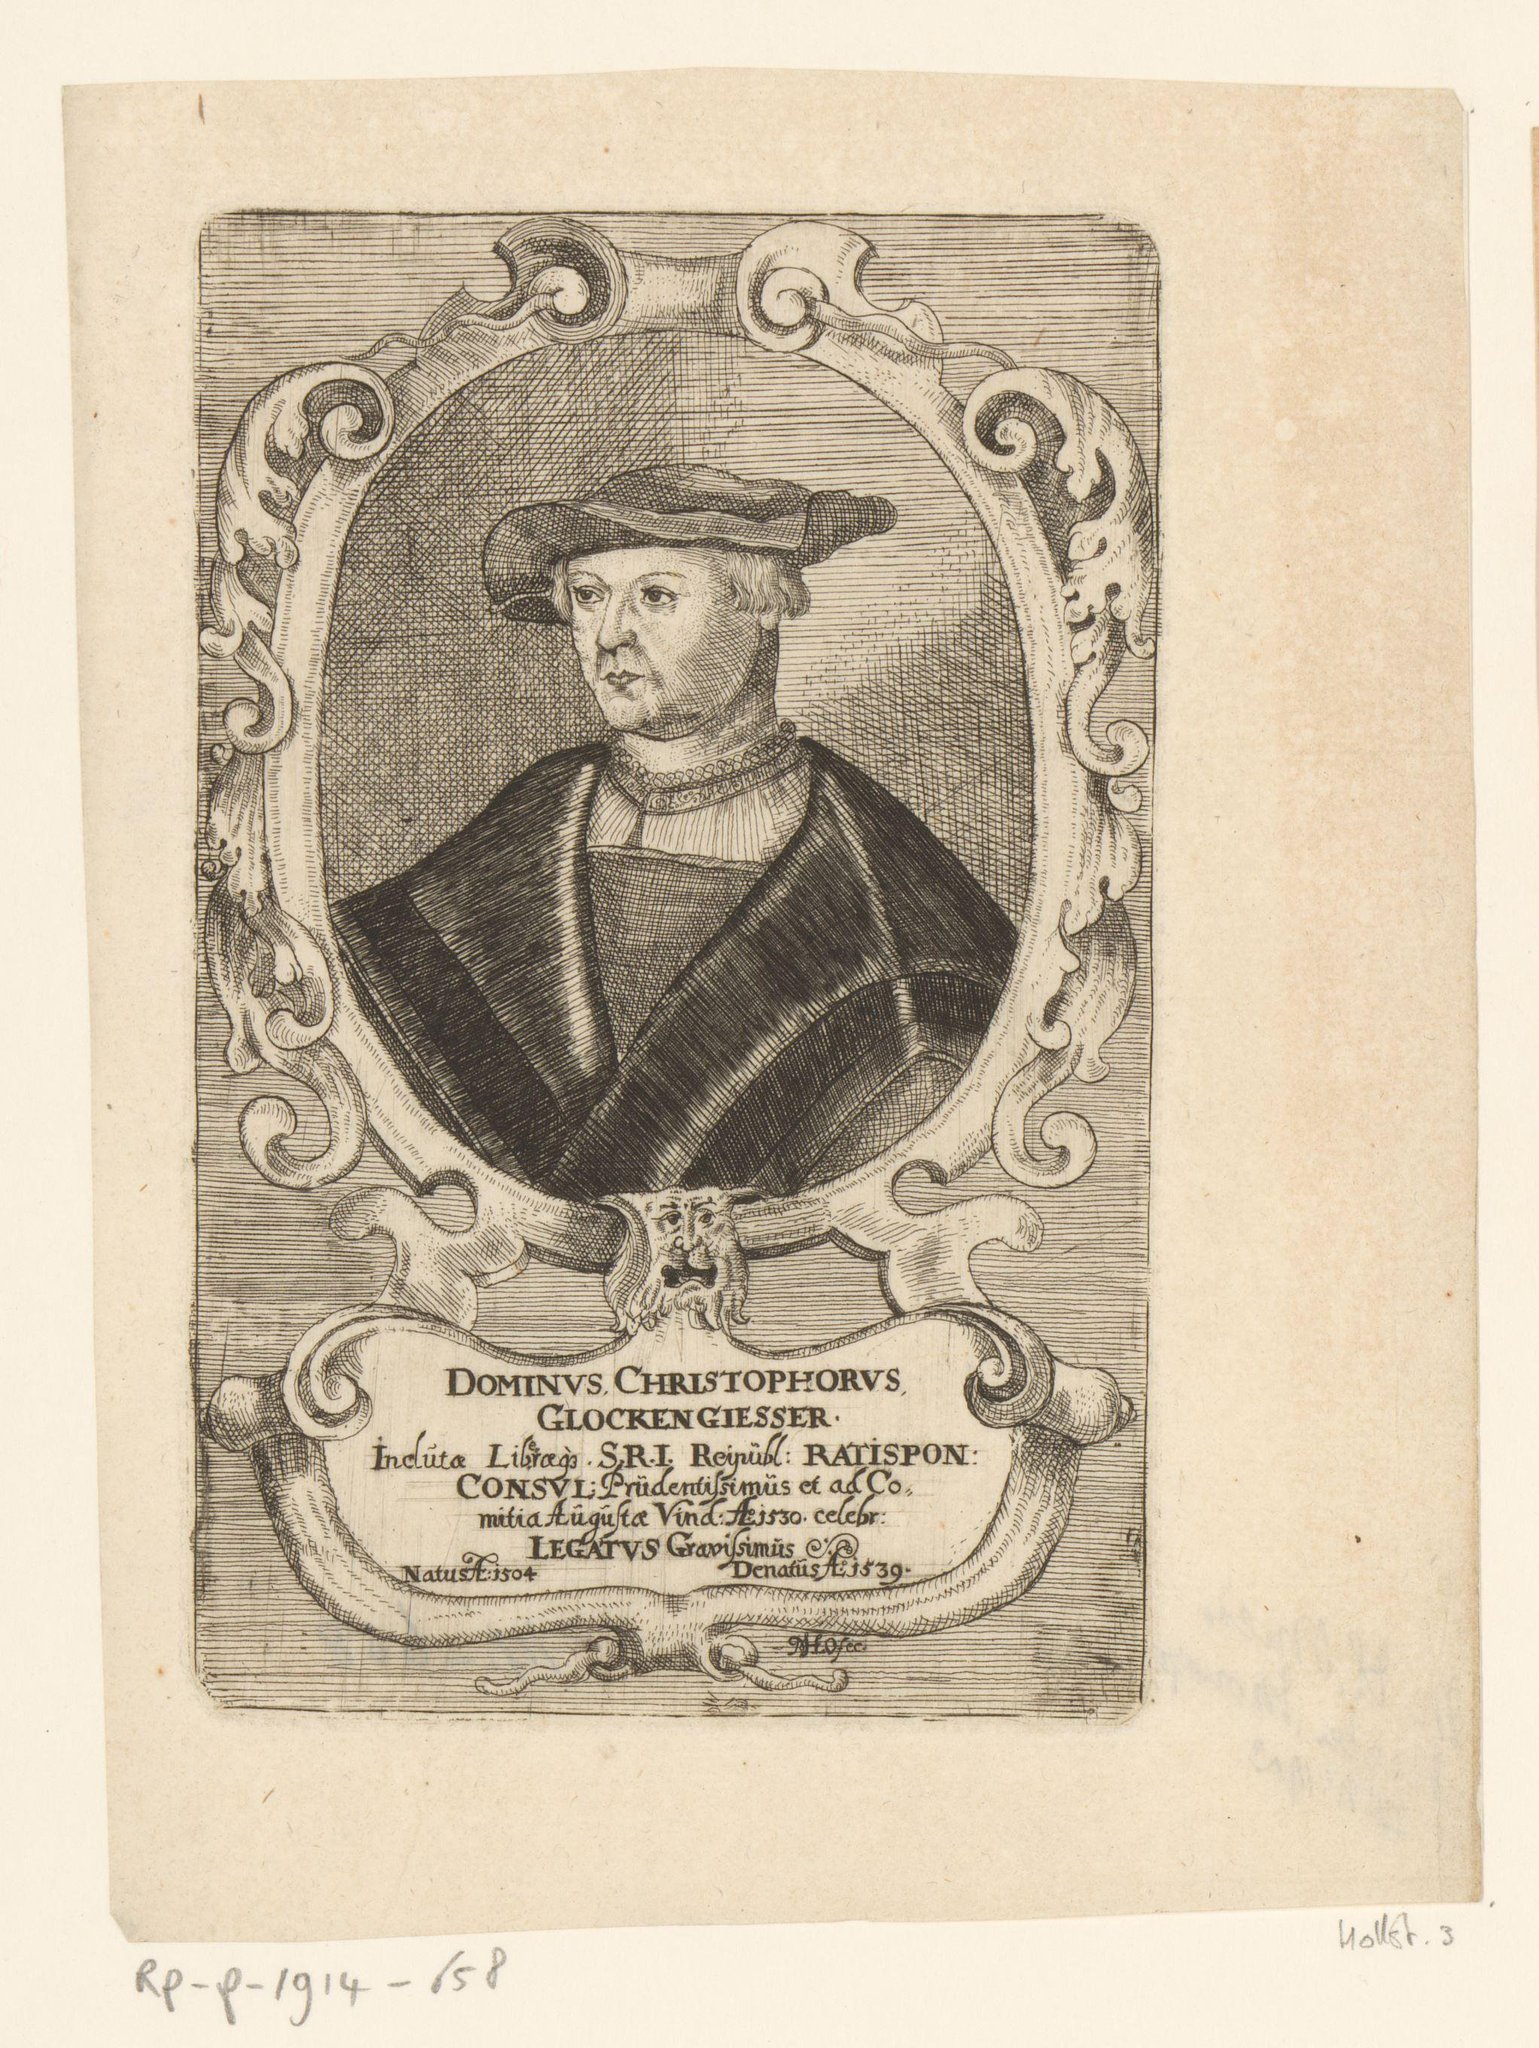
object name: print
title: Christoph Glockengiesser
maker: martin heinrich omeis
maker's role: print maker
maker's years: 1650-1703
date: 1665-1703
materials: paper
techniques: etching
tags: historical persons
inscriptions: collector's mark: Lugt 2228